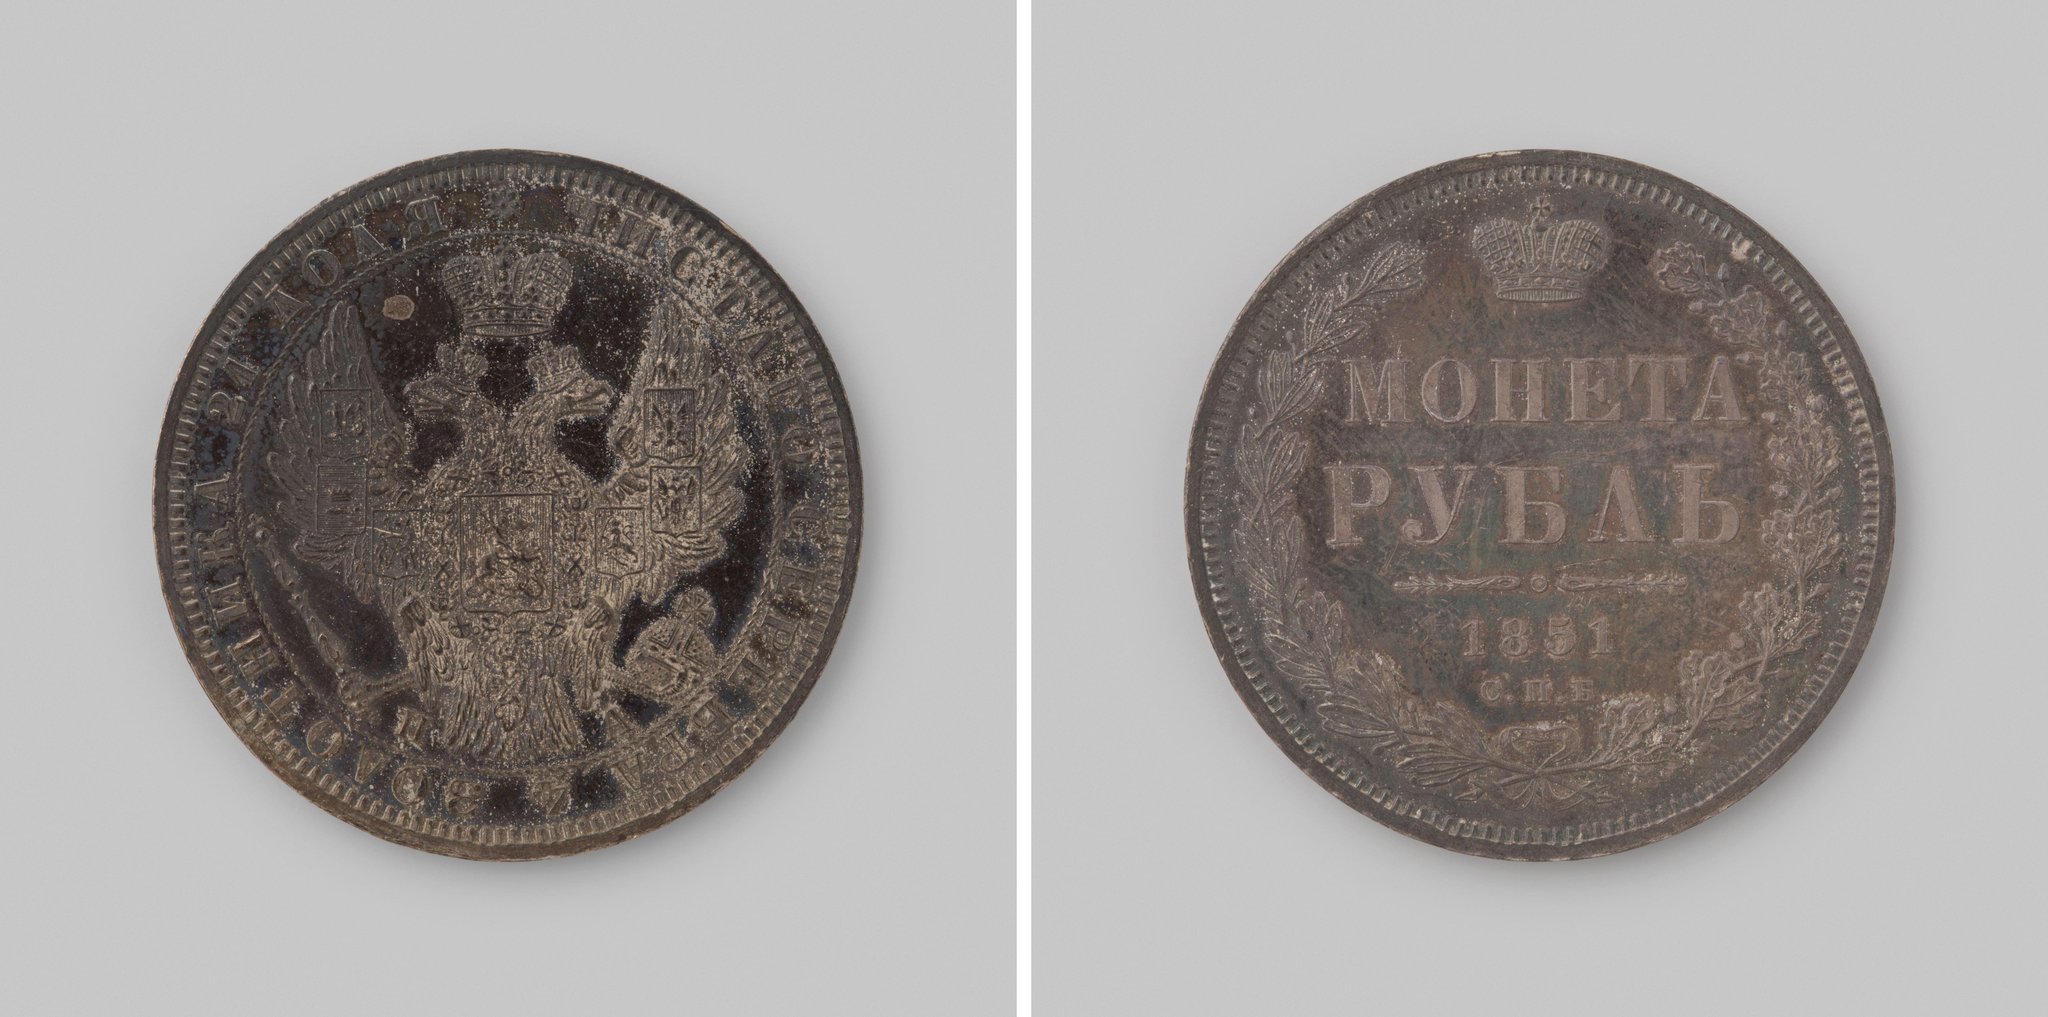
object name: coin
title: Roebel uit Rusland van tsaar Nikolai I, 1851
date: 1851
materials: silver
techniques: striking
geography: sint-petersburg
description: Zilveren munt. Voorzijde: dubbelkoppige gekroonde adelaar met gespreide vleugels, met op zijn vleugels wapenschilden en op zijn borst een groter, met een ridderorde omhangen wapenschild en met in zijn poten een scepter en een bol, waarop kruis. Boven de adelaar een kroon. Waarde-aanduiding en jaartal in het omschrift. Keerzijde: binnen twee samengebonden takken onder een kroon opschrift in twee regels. Daaronder jaartal, waaronder de letters S, P en B in Cyrillisch schrift. Randschrift.